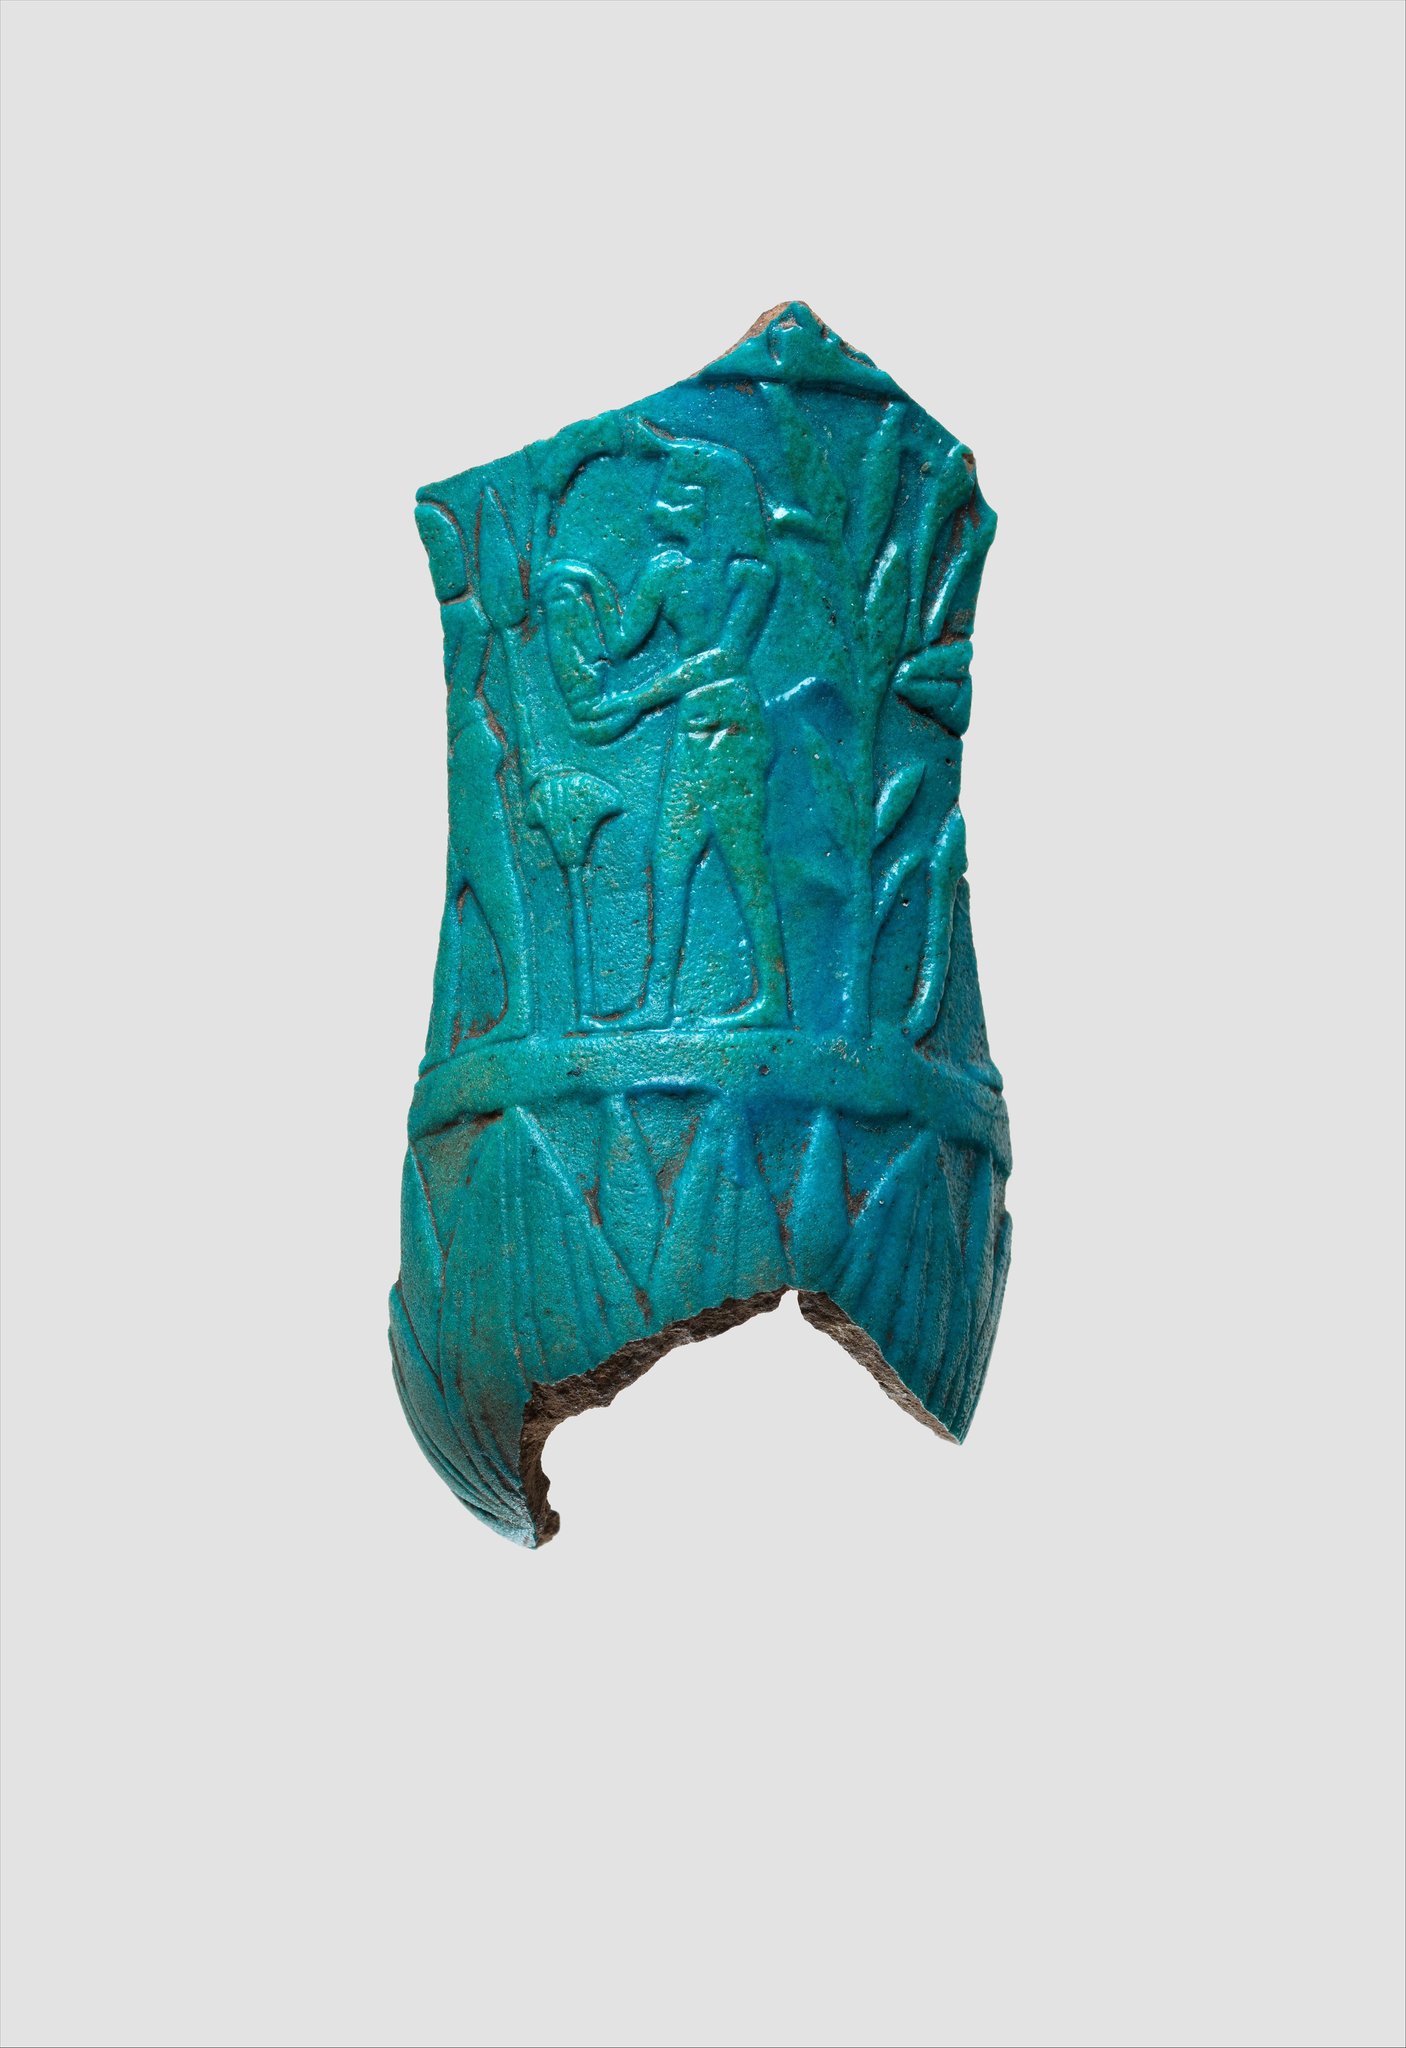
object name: chalice, cup, lotiform, relief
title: Chalice fragment showing a file of nude females in a marshy landscape, inscribed, associated with 2013.635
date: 945-712 BCE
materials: faience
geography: egypt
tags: female nudes